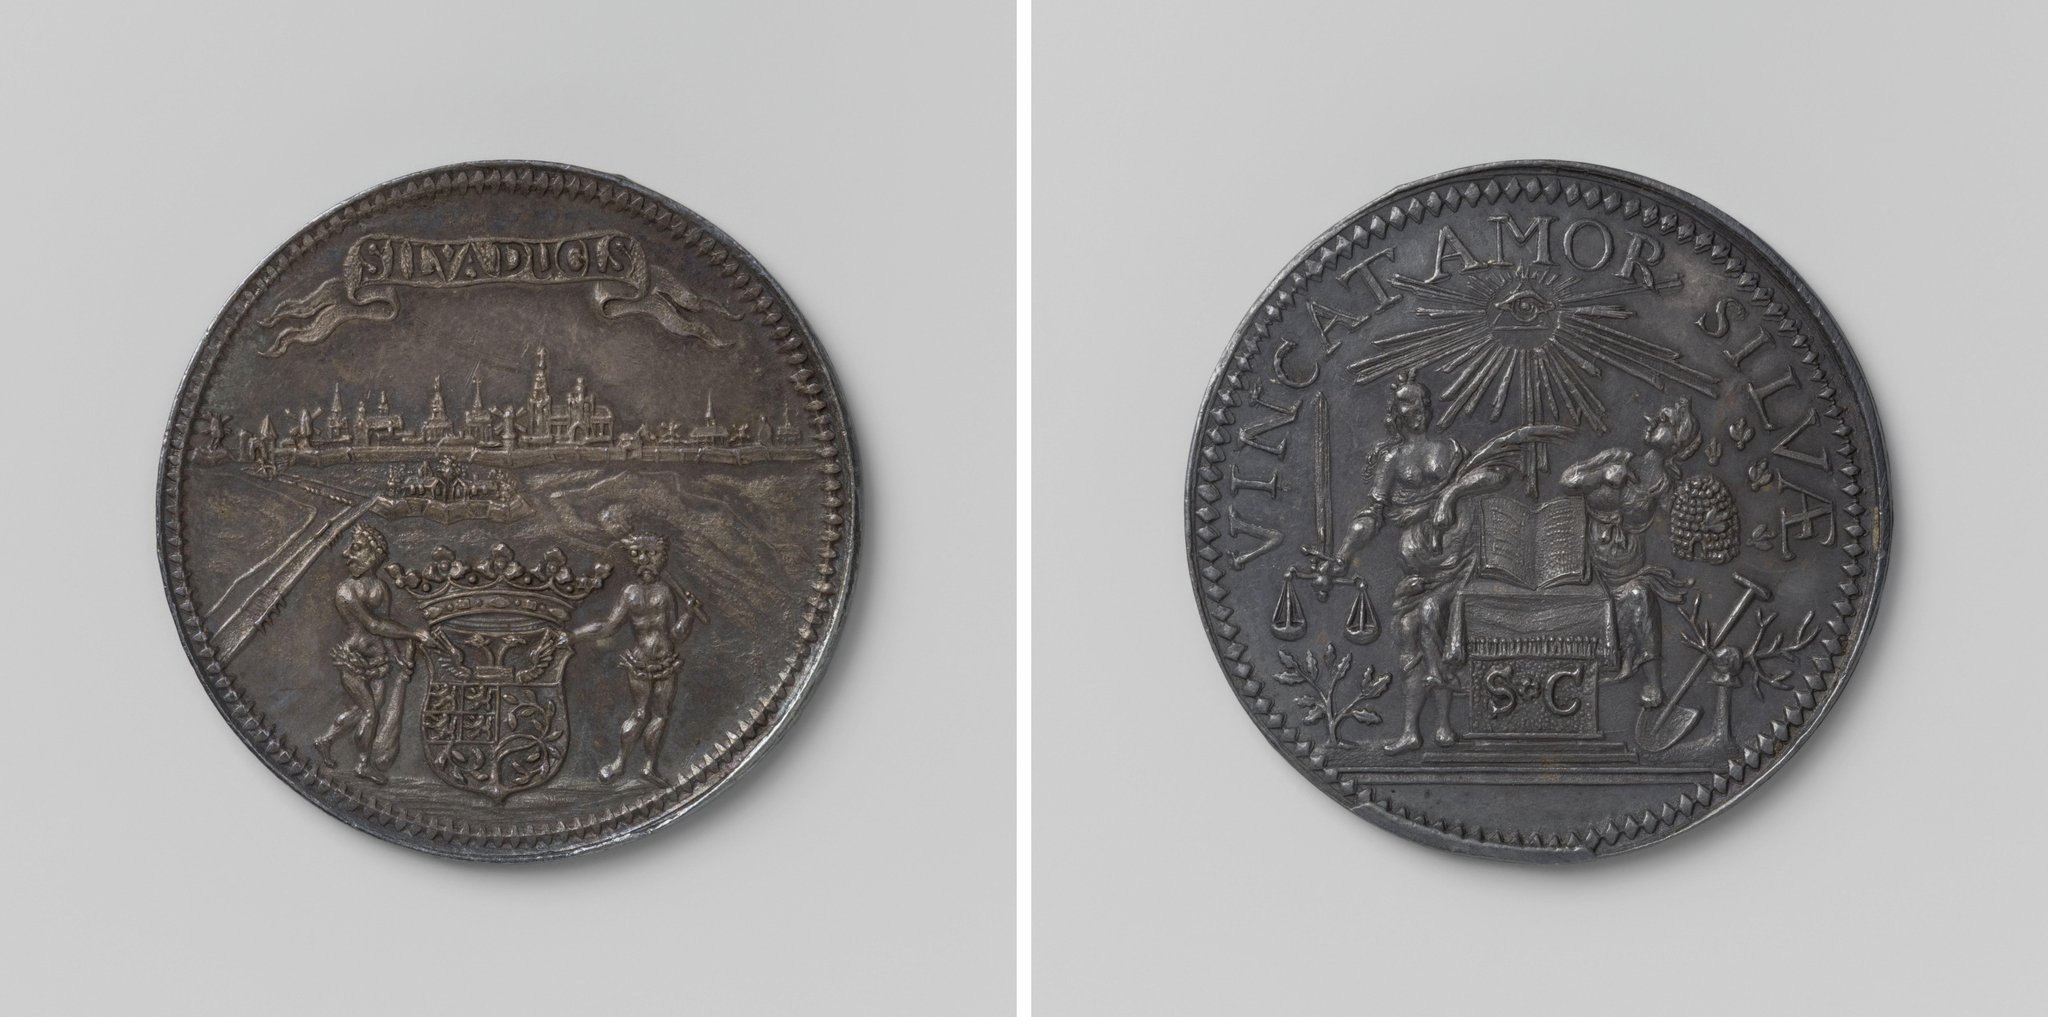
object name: council medal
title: Vroedschapspenning van de stad 's-Hertogenbosch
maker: theodorus casparus van berckel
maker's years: 1680-1734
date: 1707-1710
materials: silver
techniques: striking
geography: den bosch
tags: den bosch